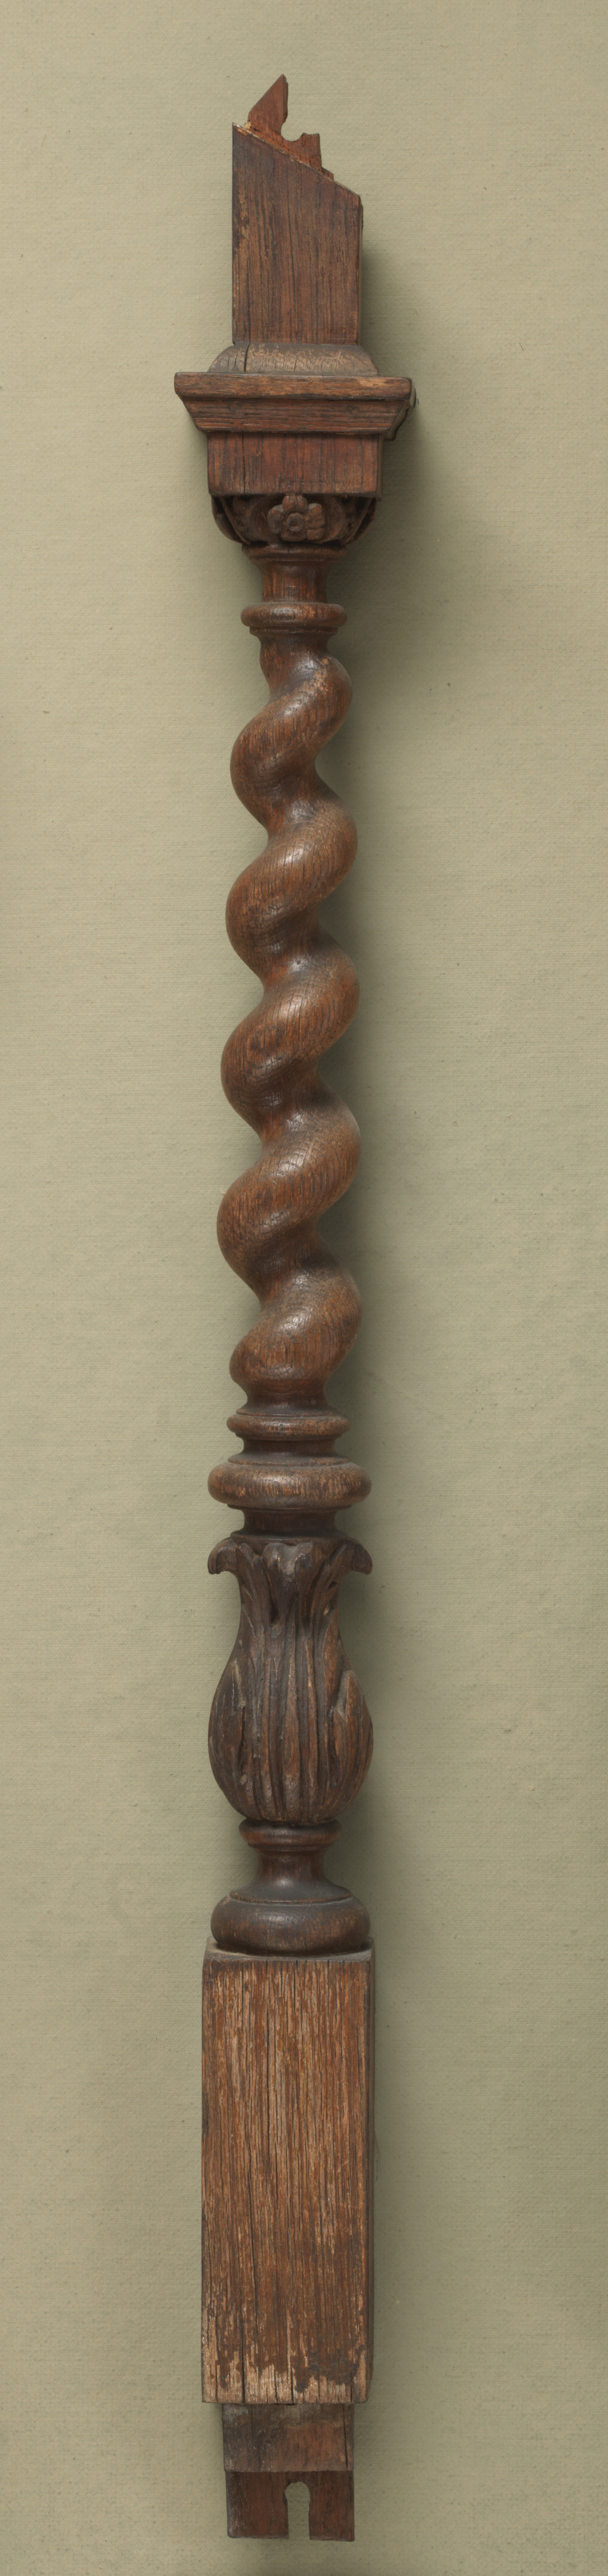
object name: baluster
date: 1693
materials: wood